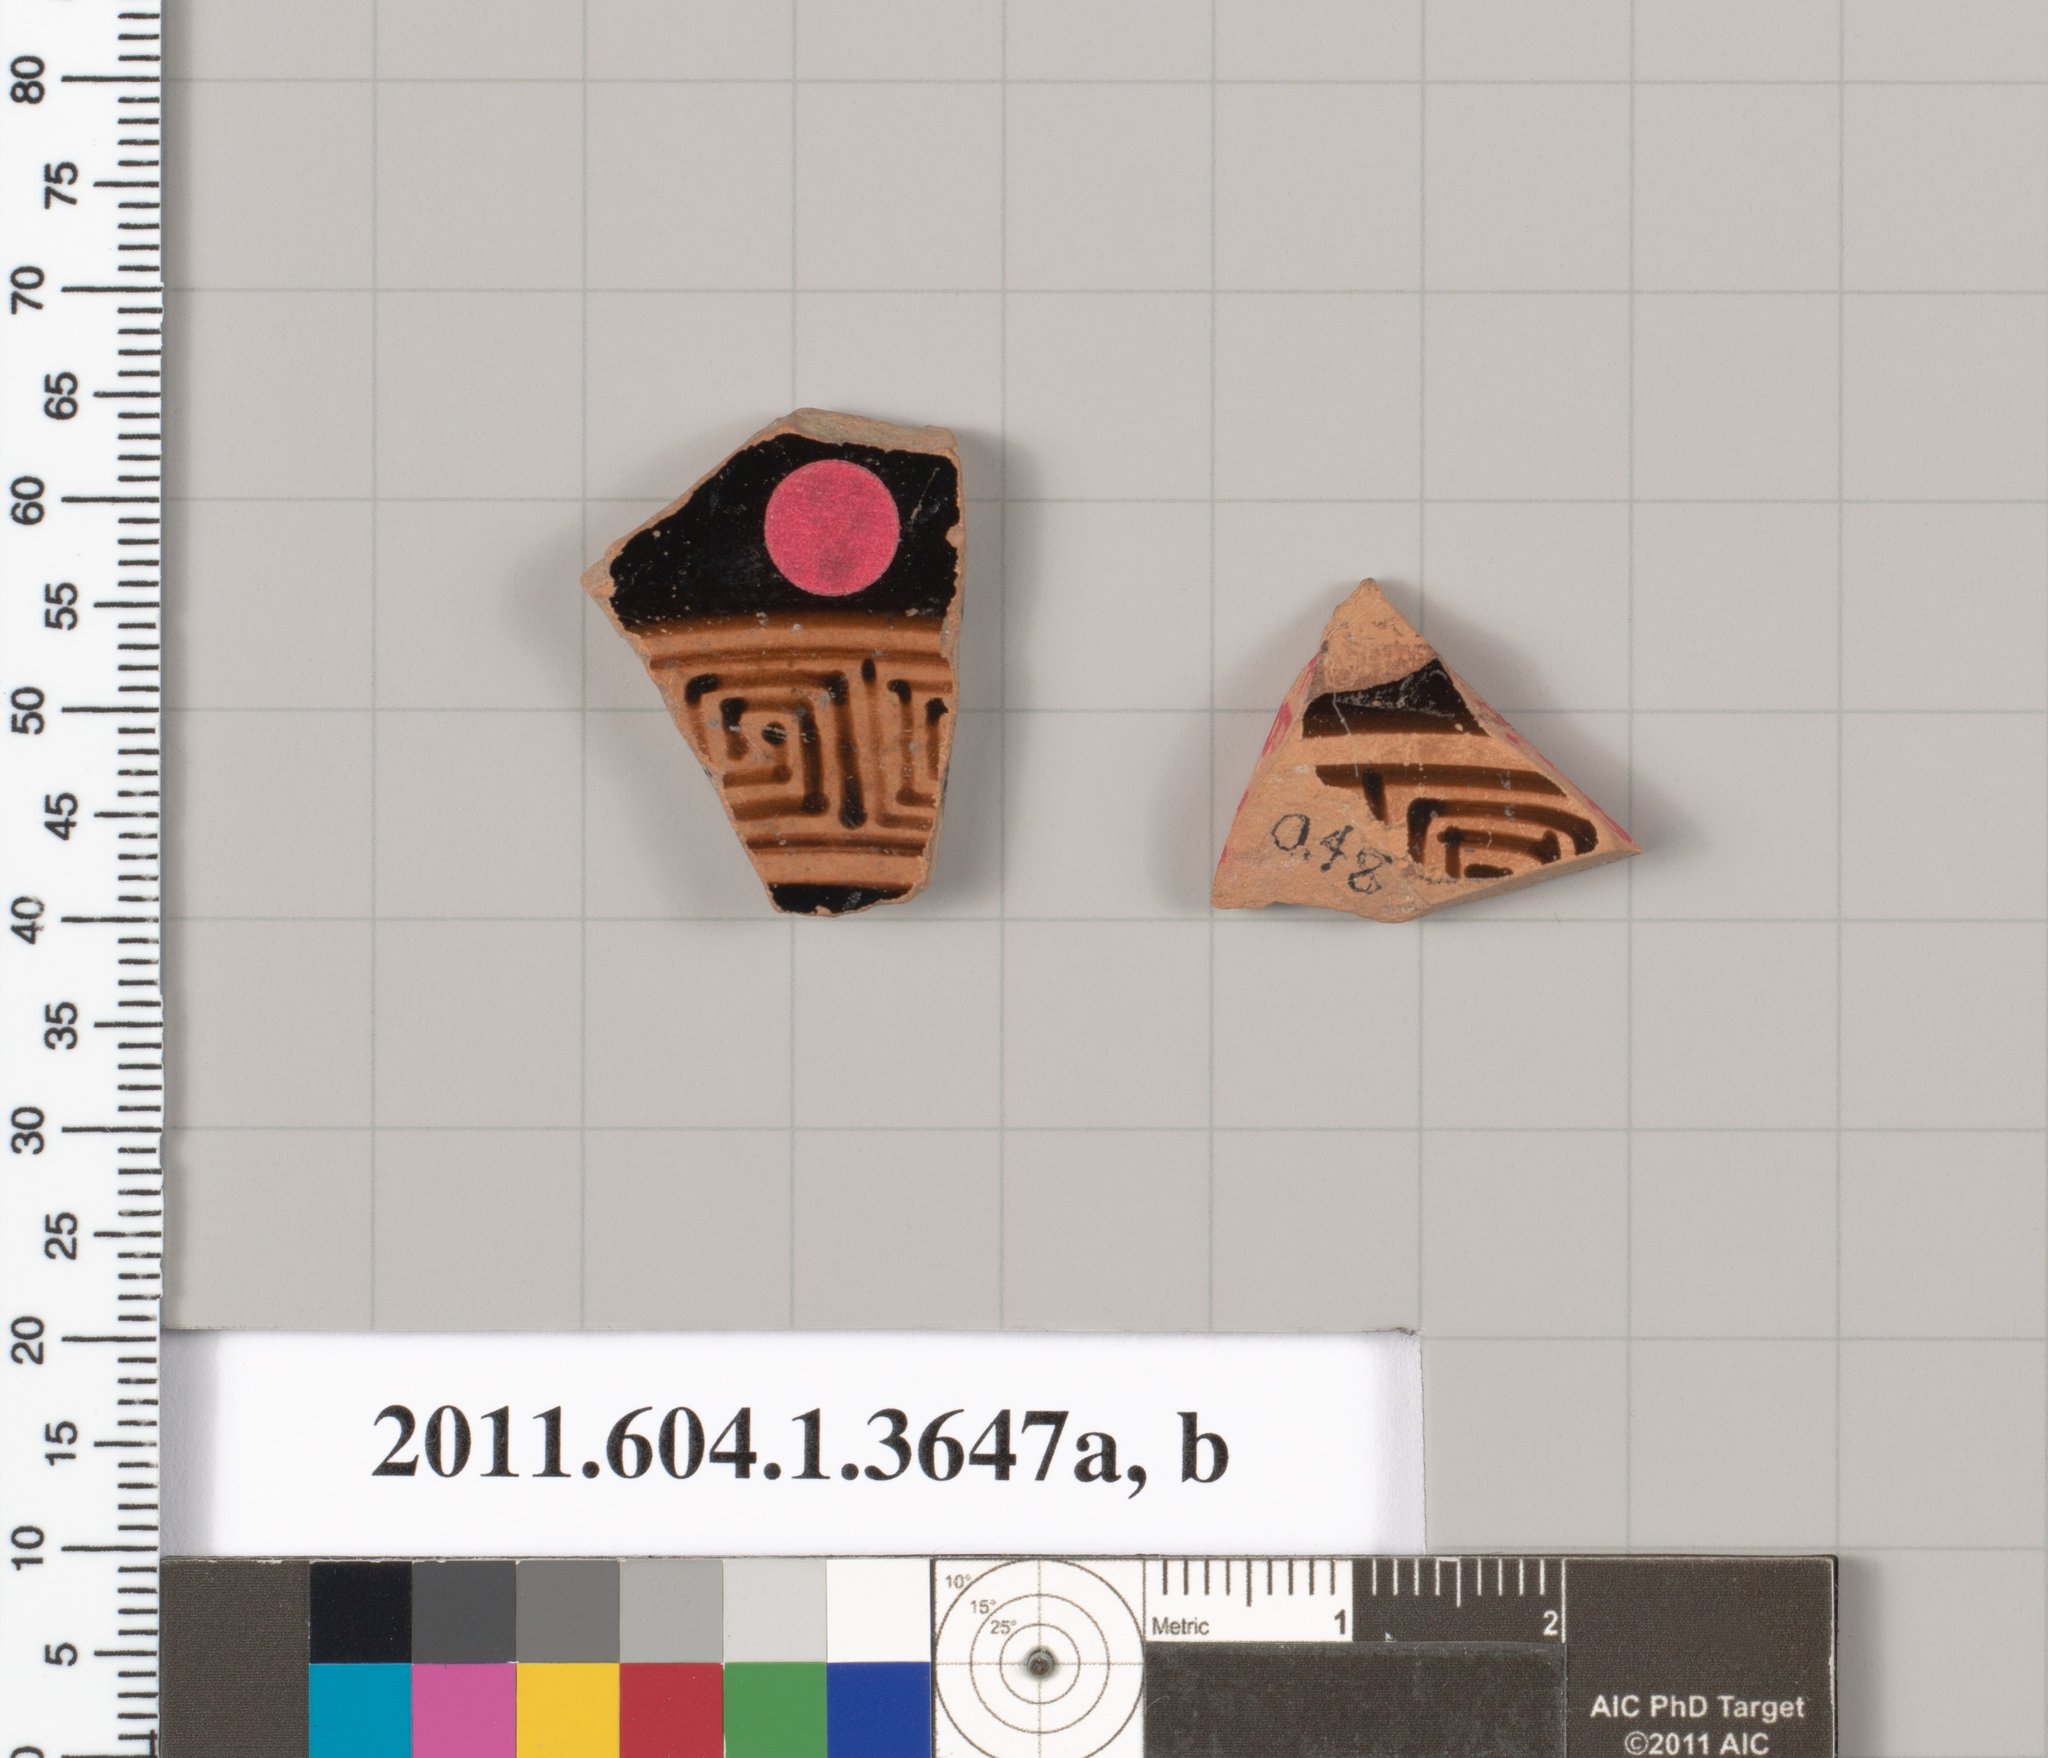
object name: kylix fragment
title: Terracotta fragments of kylikes (drinking cups)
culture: greek, attic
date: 475-451 BCE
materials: terracotta